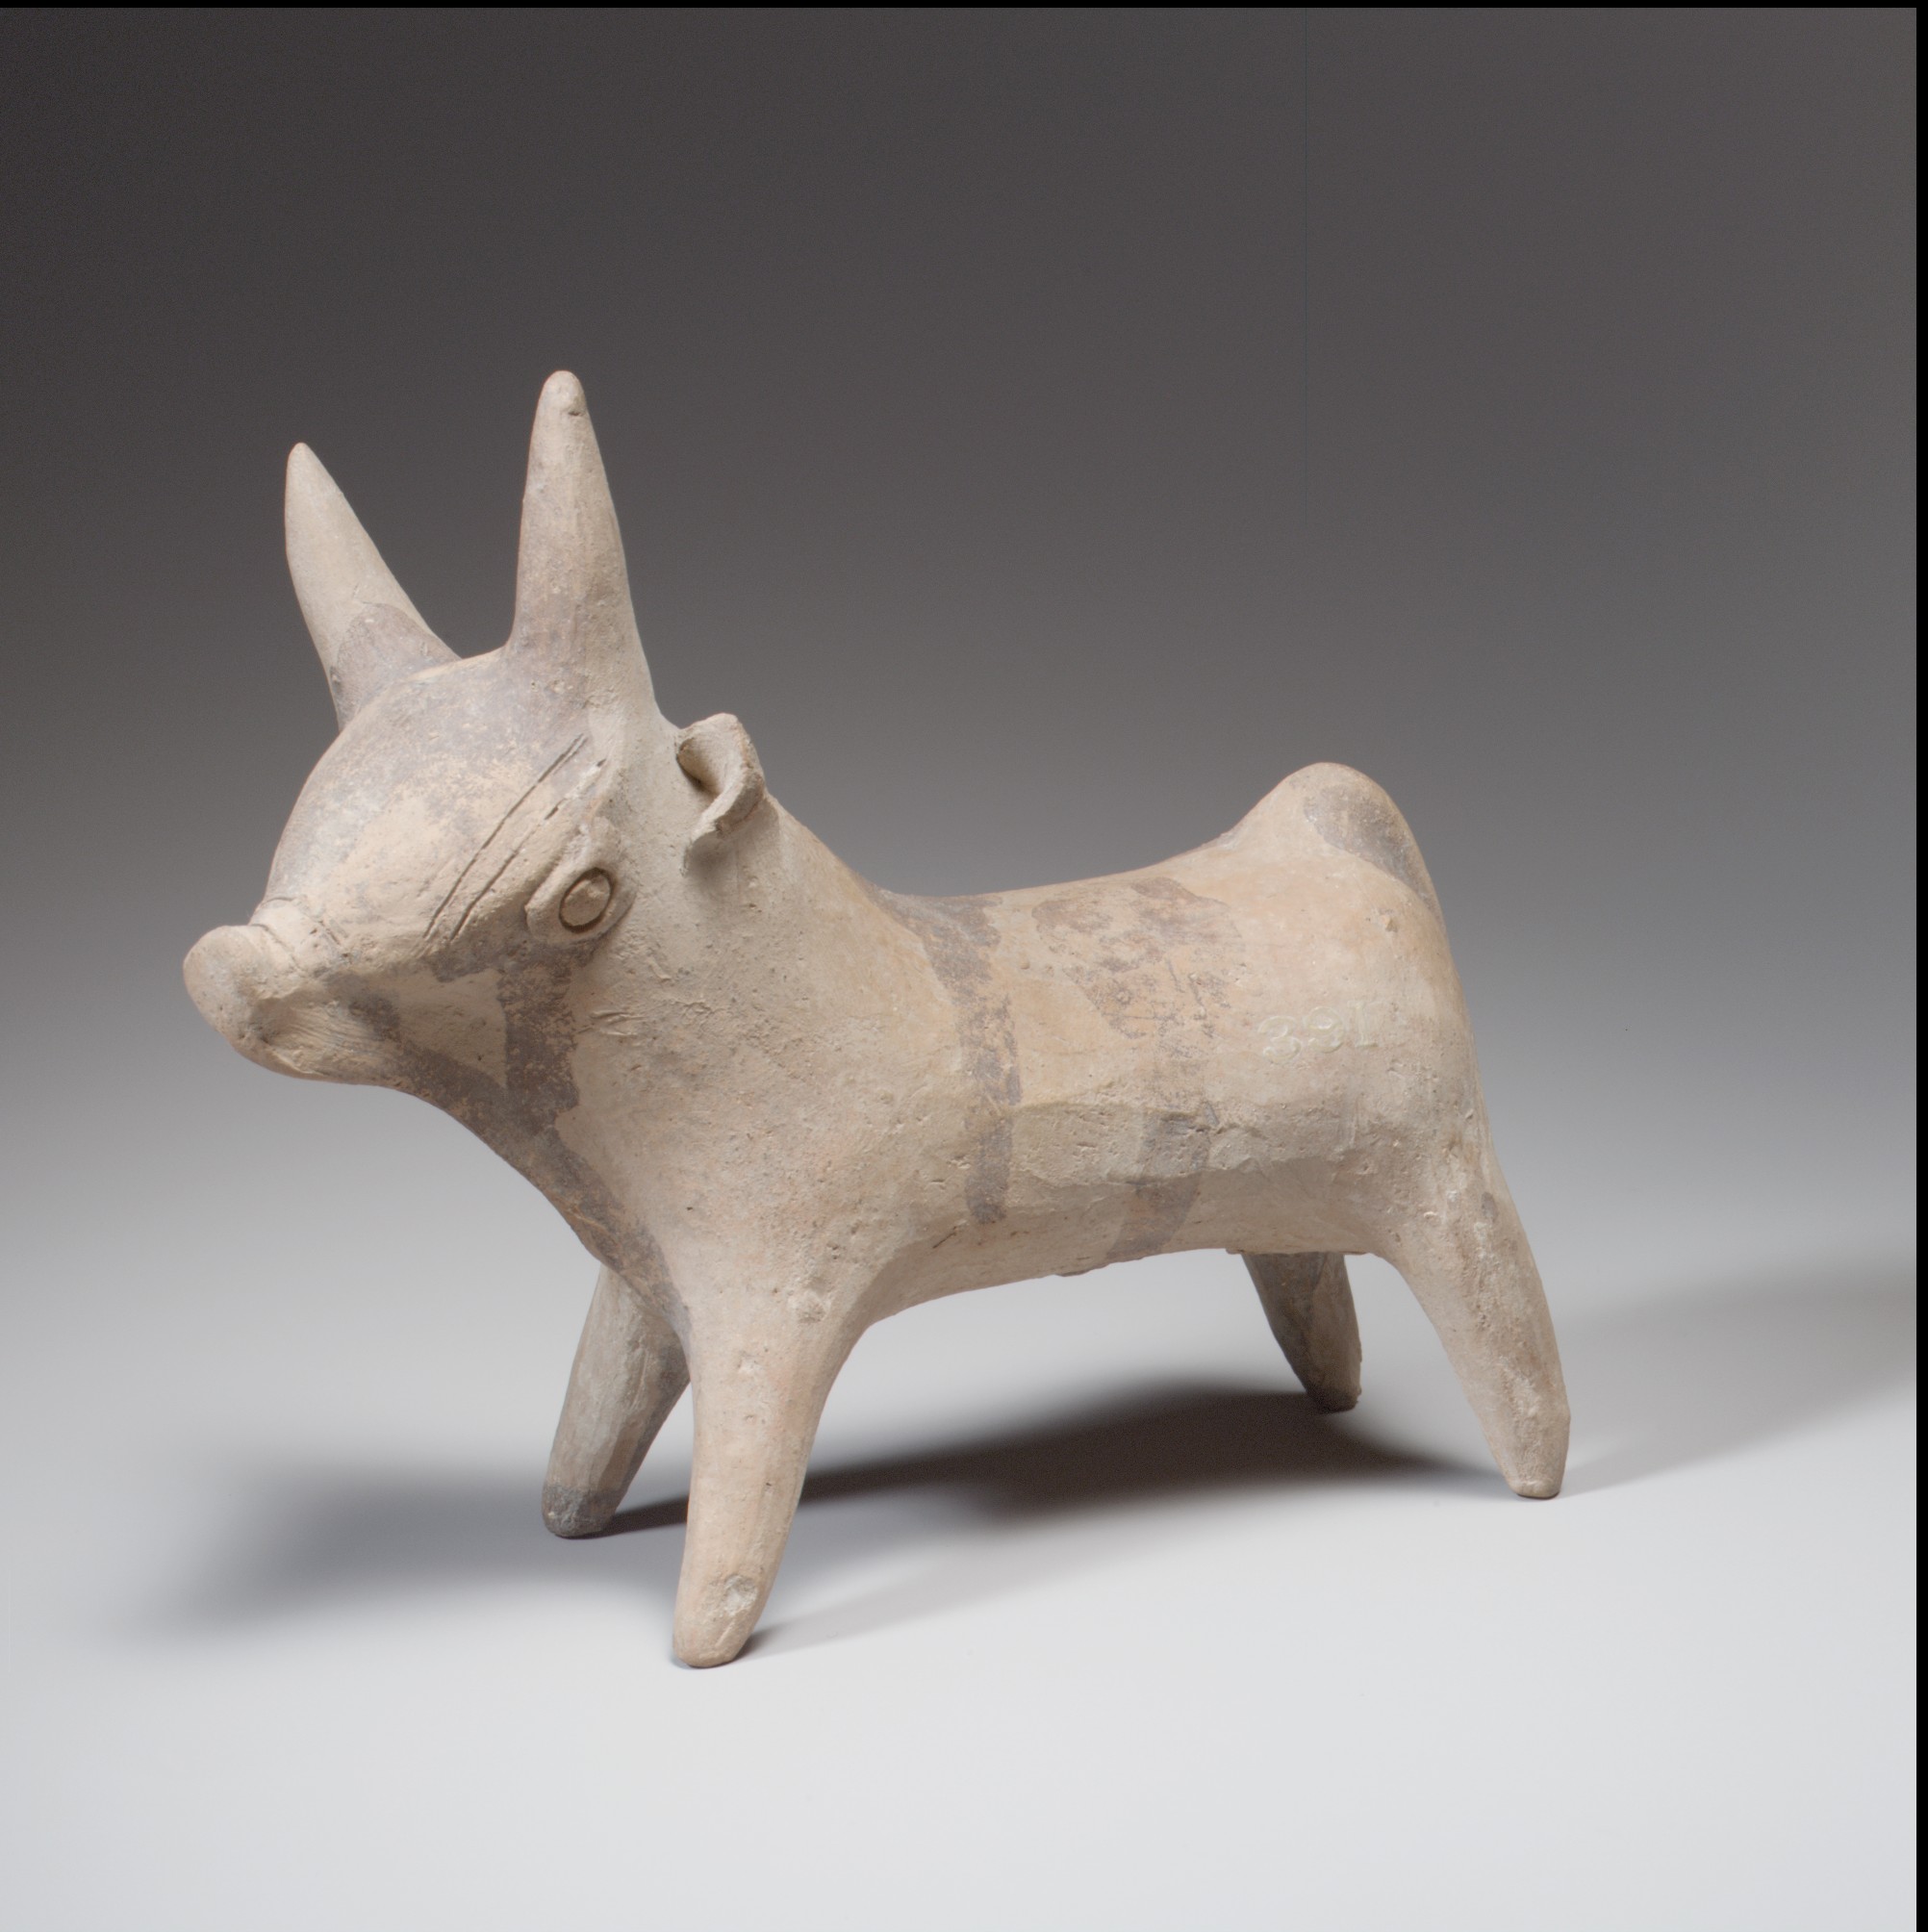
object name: vase in the form of a bull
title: Terracotta vase in the form of a bull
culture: cypriot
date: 1450-1200 BCE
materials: terracotta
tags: bulls